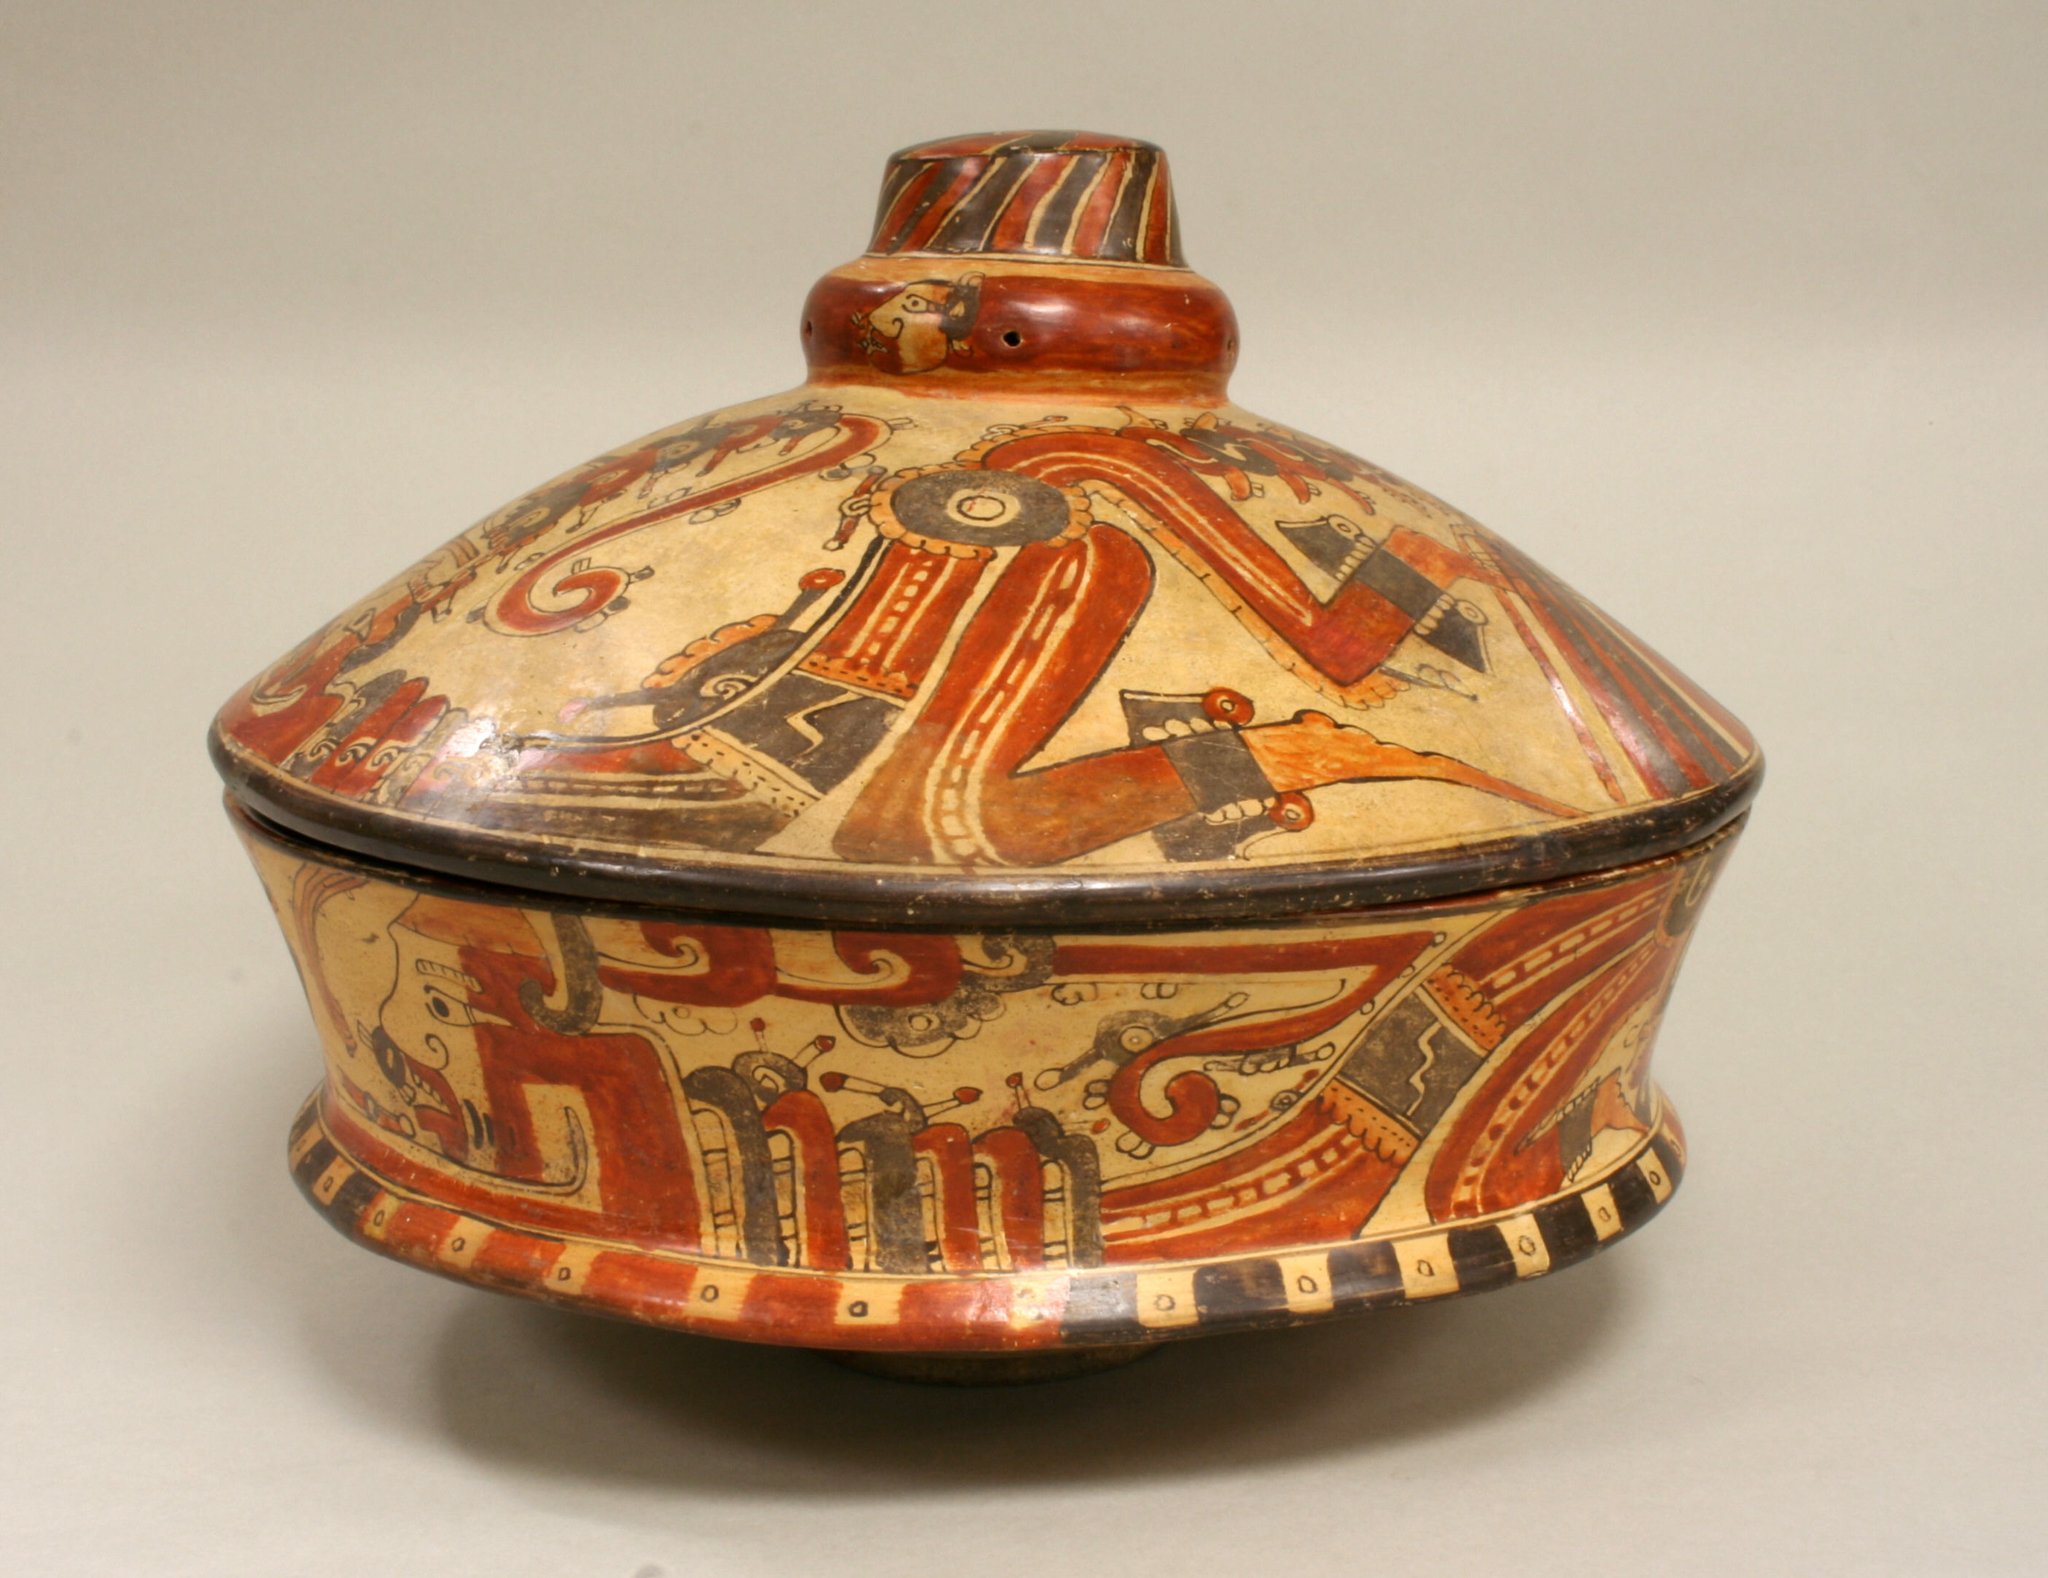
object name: bowl with lid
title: Lidded Vessel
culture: maya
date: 201-400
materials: ceramic, pigment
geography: guatemala